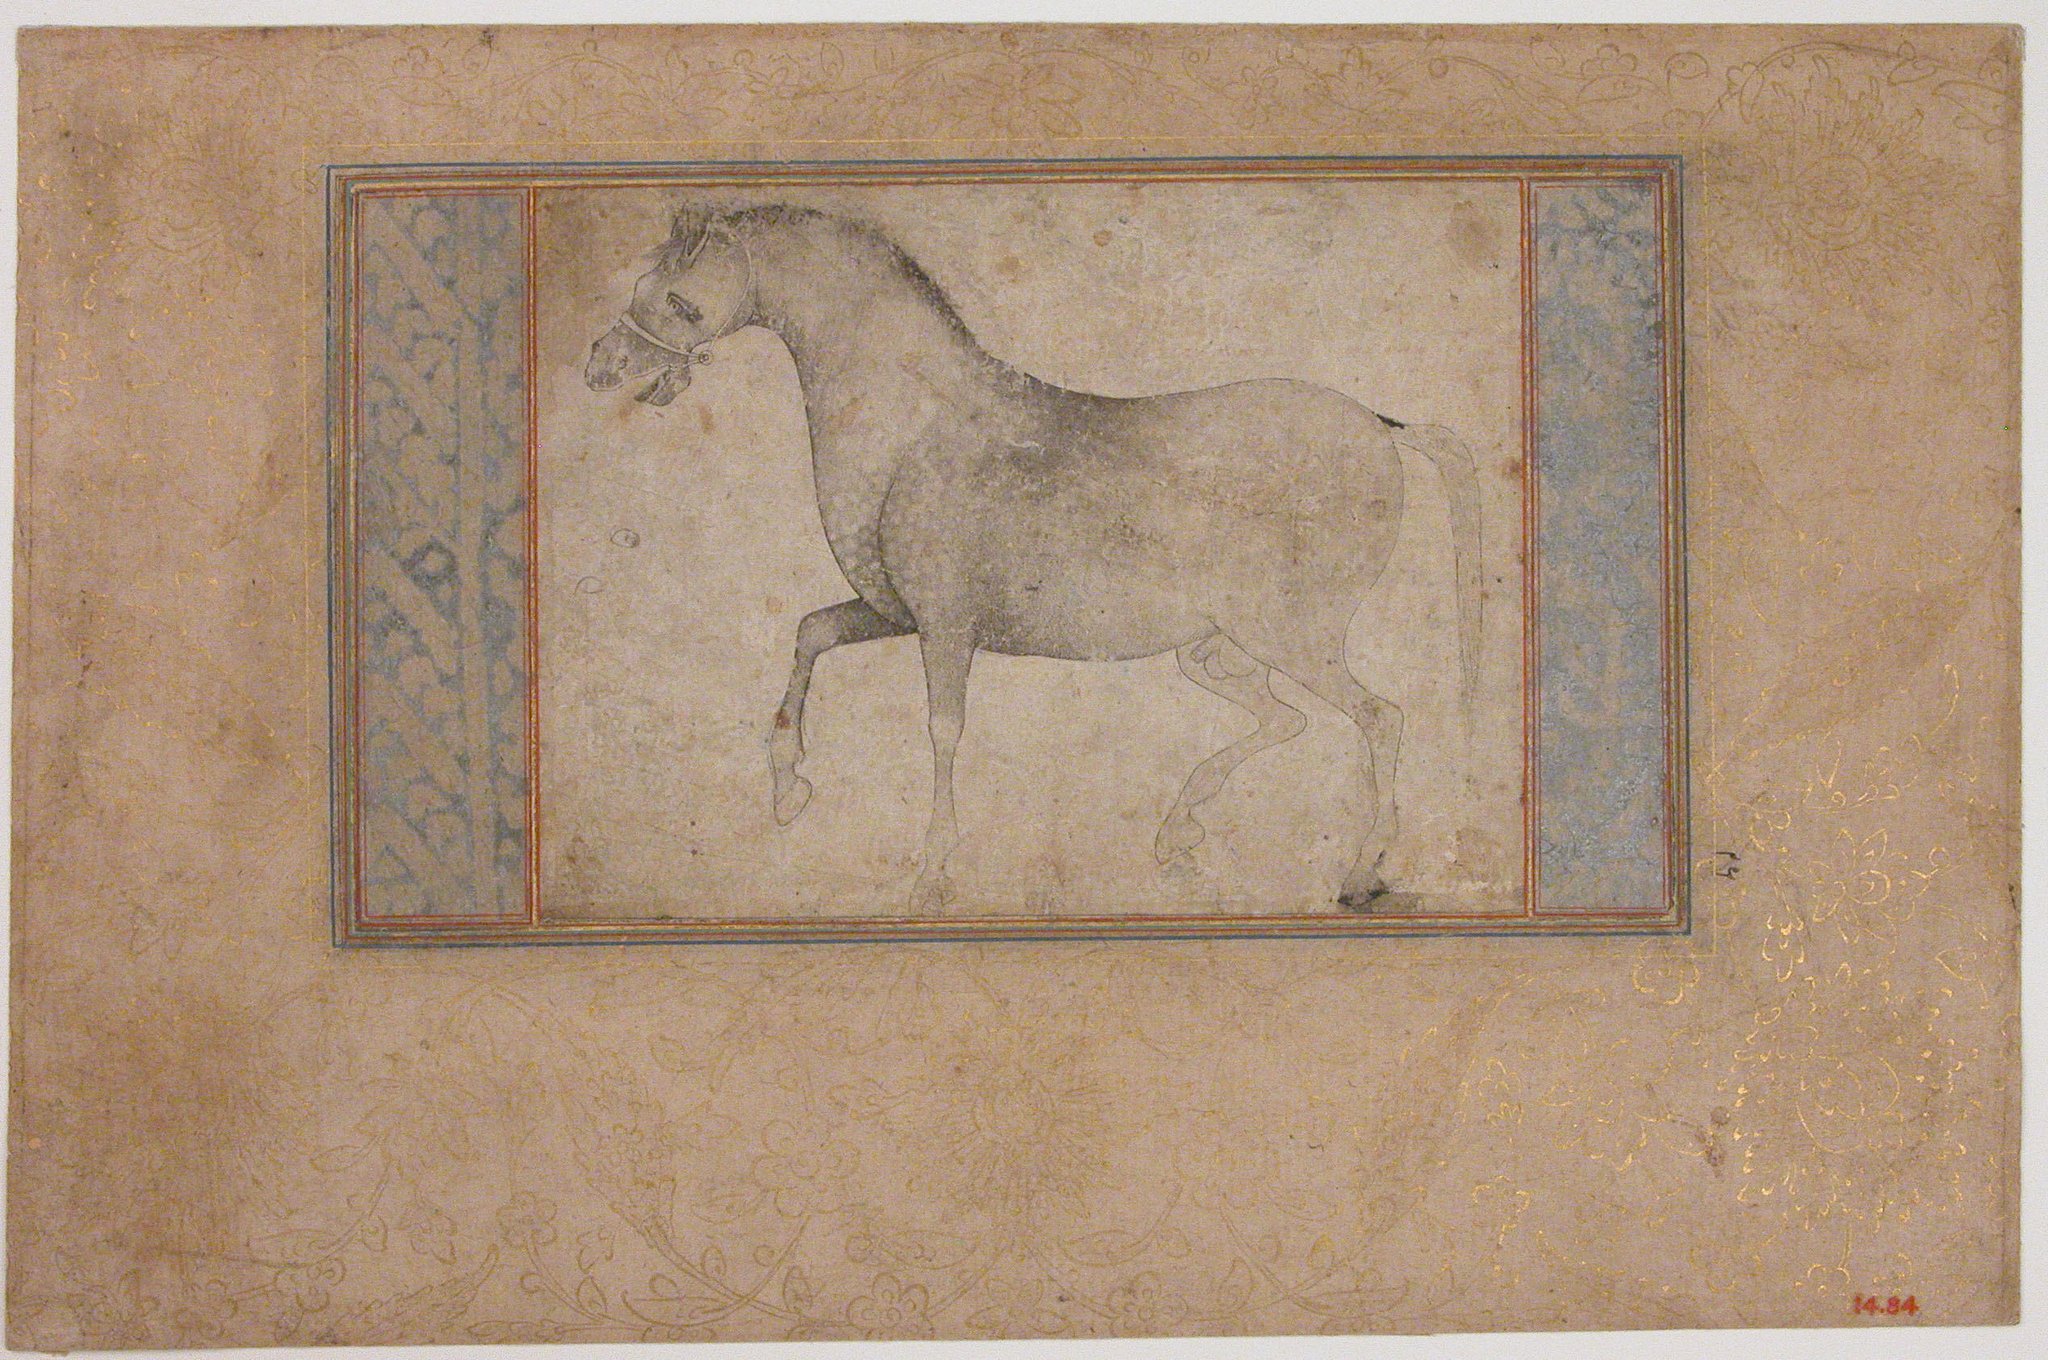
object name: illustrated album leaf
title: Portrait of a Stallion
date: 1701-1800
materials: ink, paper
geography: iran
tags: horses